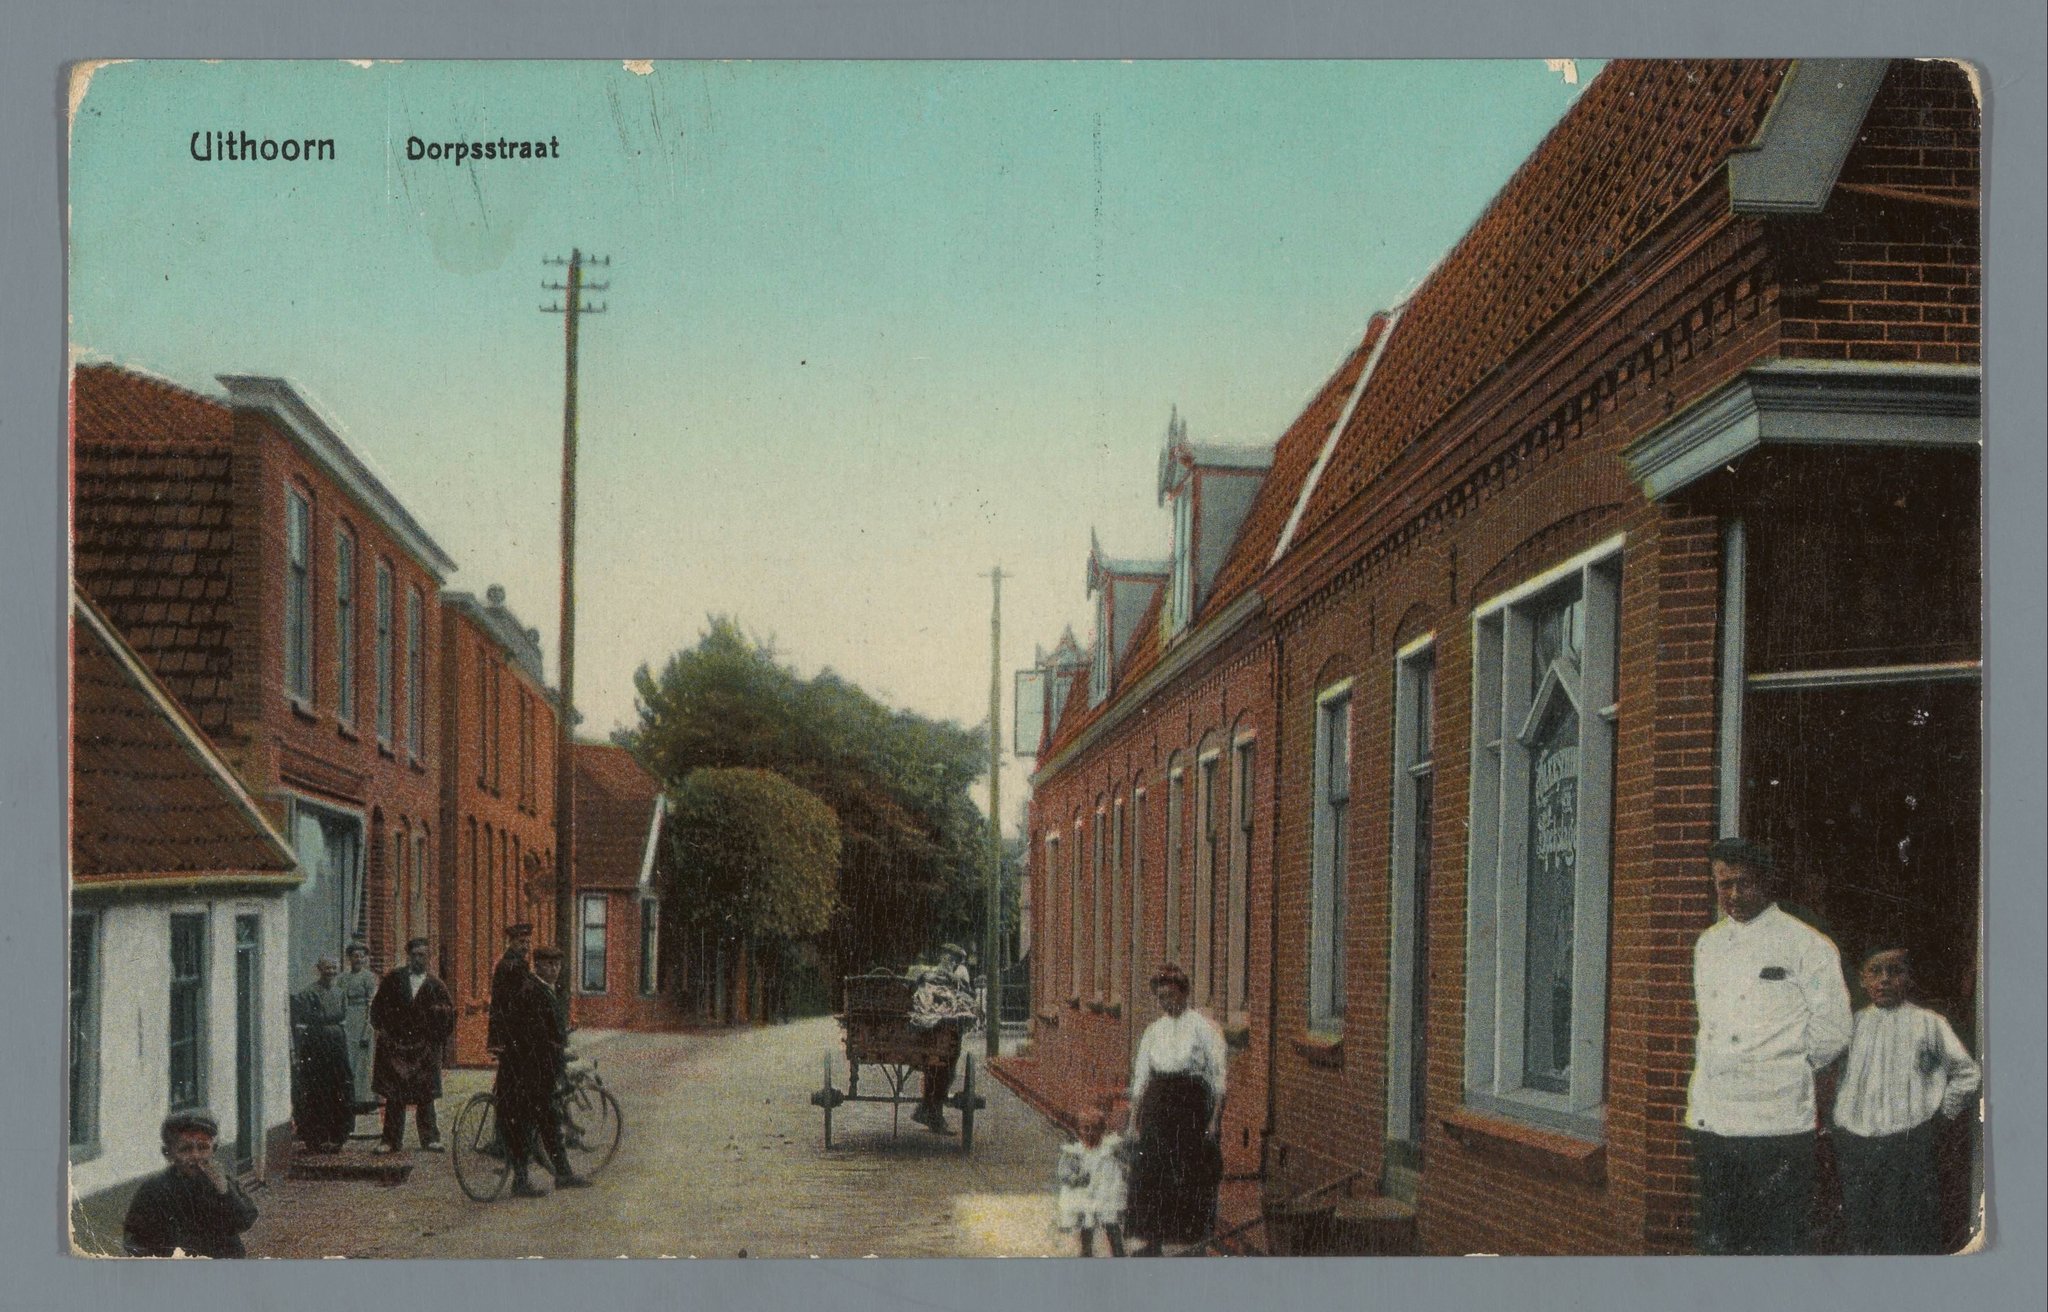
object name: photomechanical print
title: Uithoorn, Dorpsstraat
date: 1890-1920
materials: cardboard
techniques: photograph, writing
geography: uithoorn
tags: street